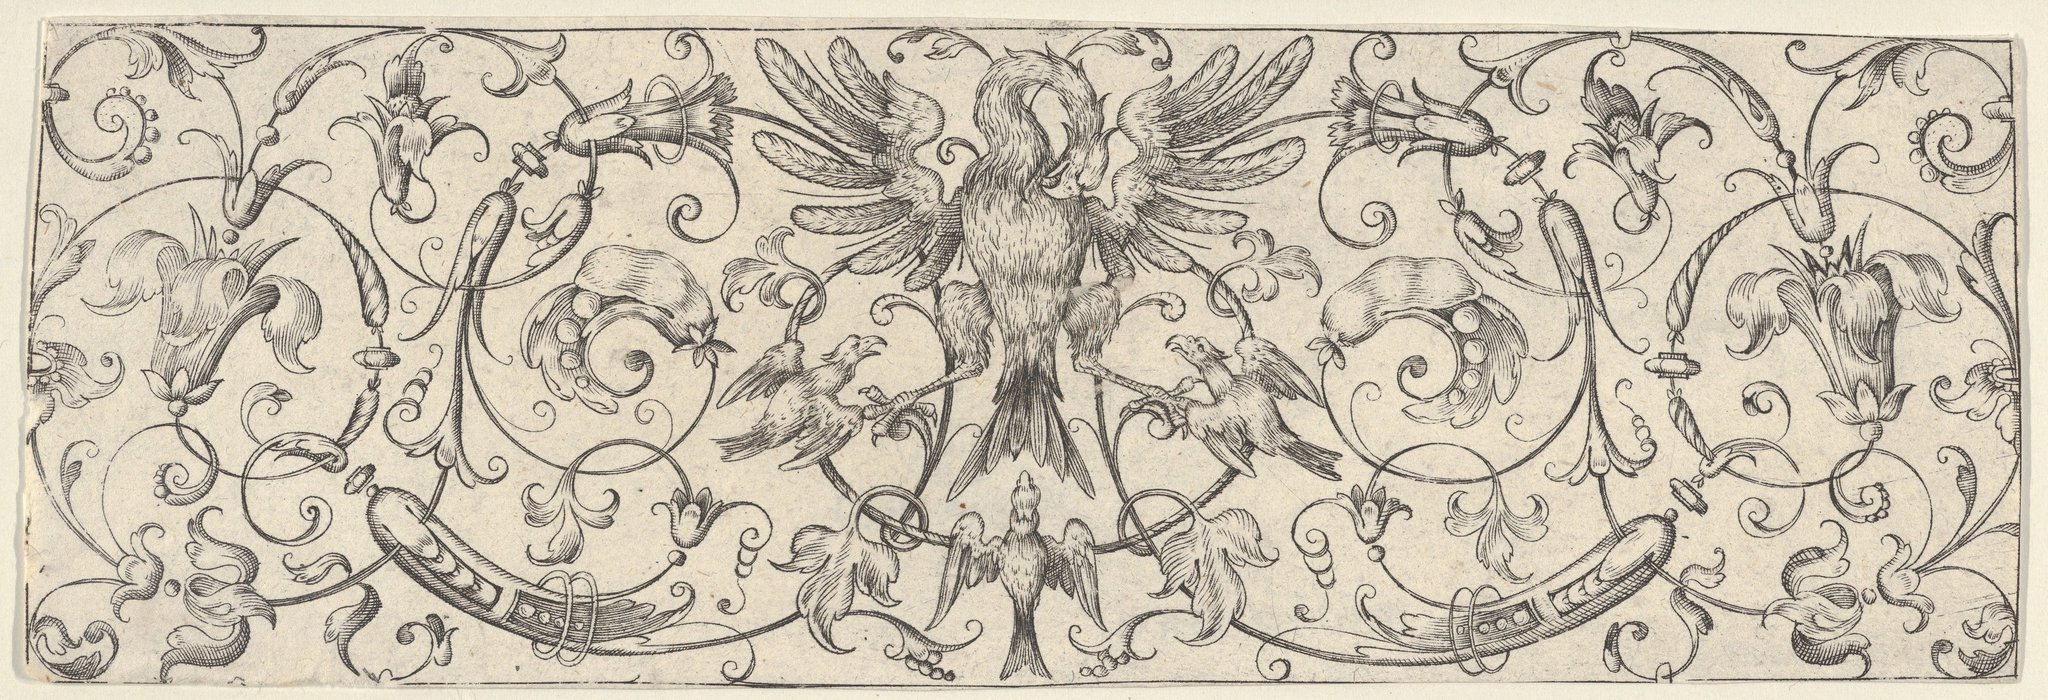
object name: ornament architecture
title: Plate 5, from "Friezes with Birds, Flowers and Meandering Wreaths and Scrolls"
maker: theodor bang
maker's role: artist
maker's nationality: german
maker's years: 1606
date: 1600-1617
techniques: etching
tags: birds,flowers